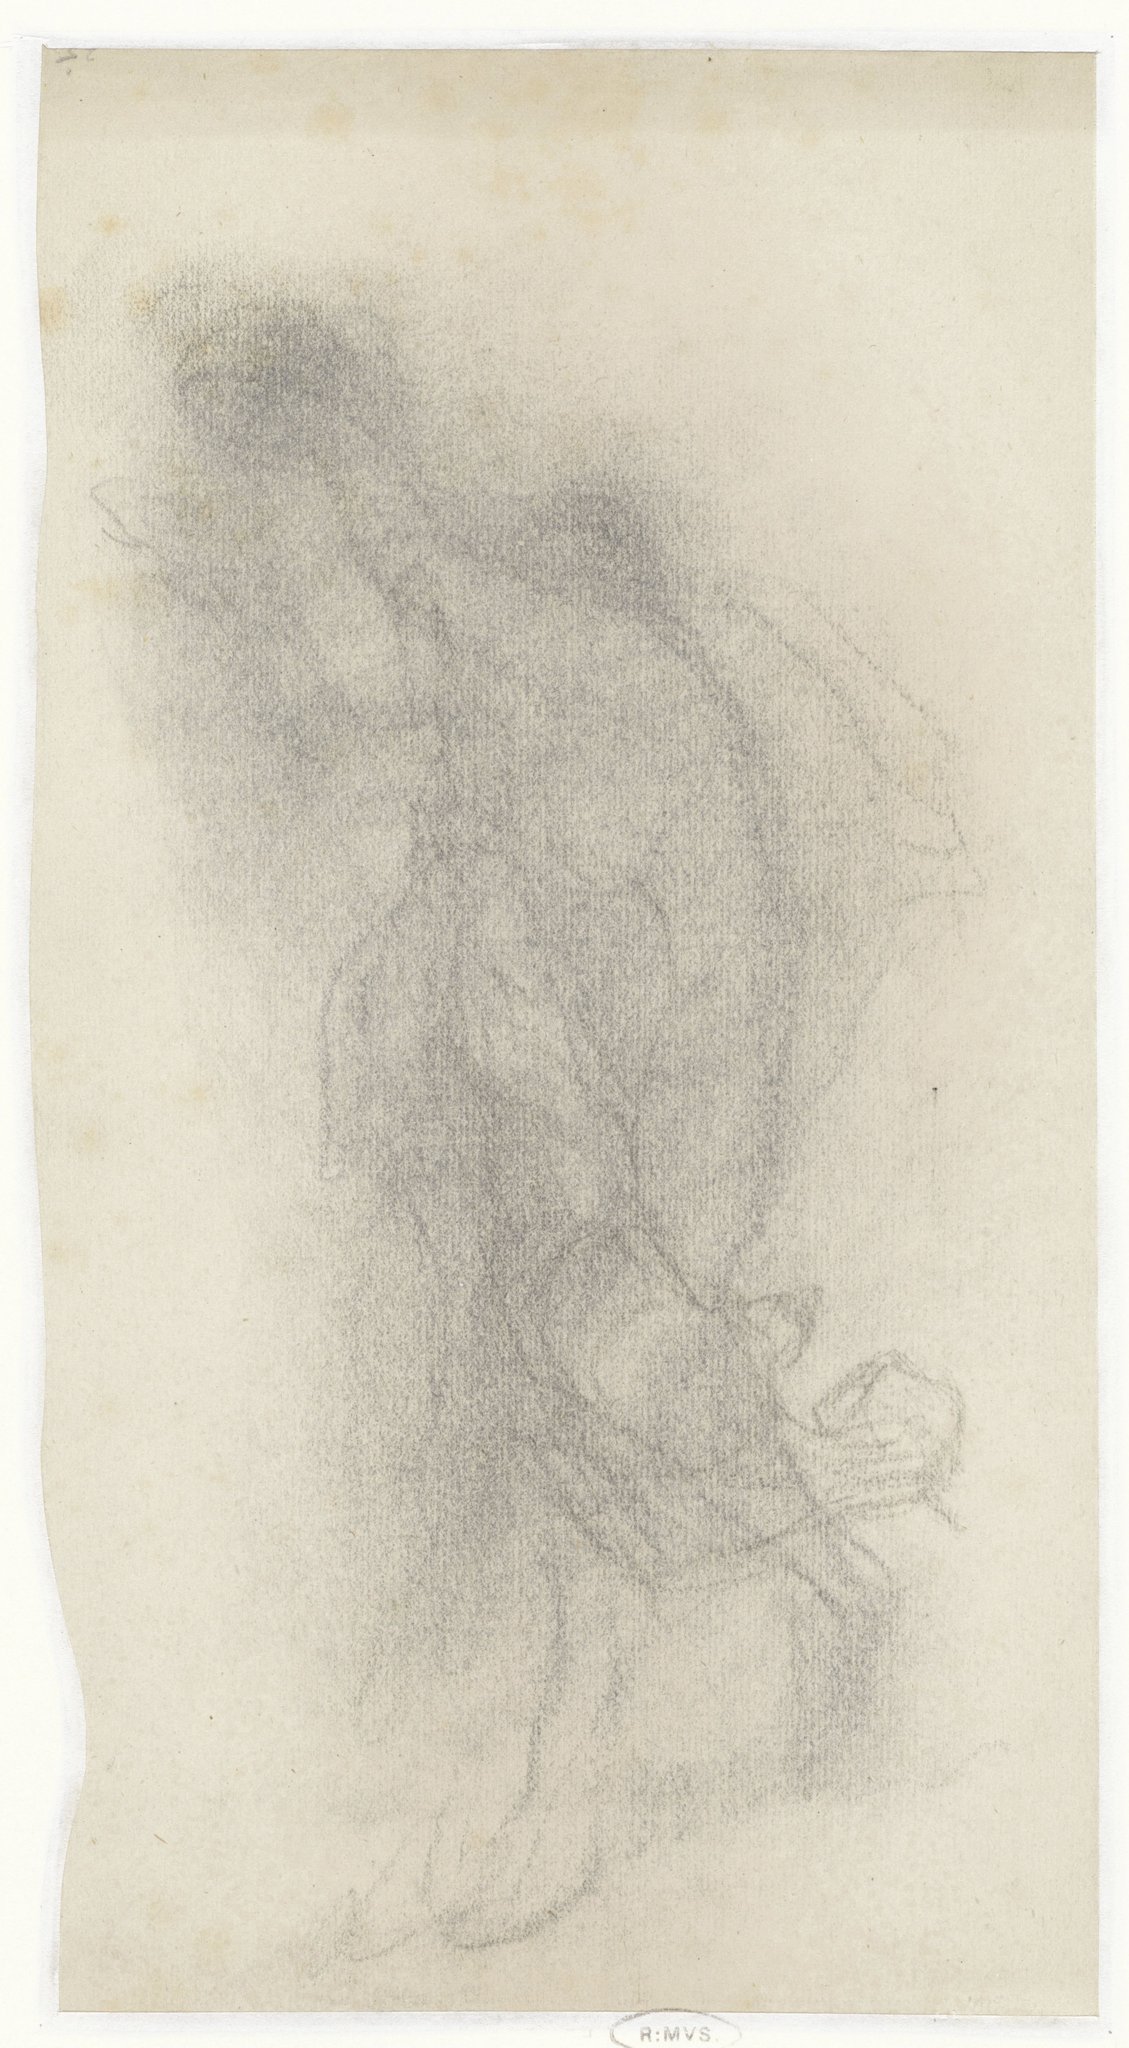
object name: drawing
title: Dansende figuur, naar links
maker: matthijs maris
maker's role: draughtsman, painter, print maker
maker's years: 1839-1917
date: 1849-1917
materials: chalk, paper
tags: ritual music and dancing ~ non-christian religions, dancing